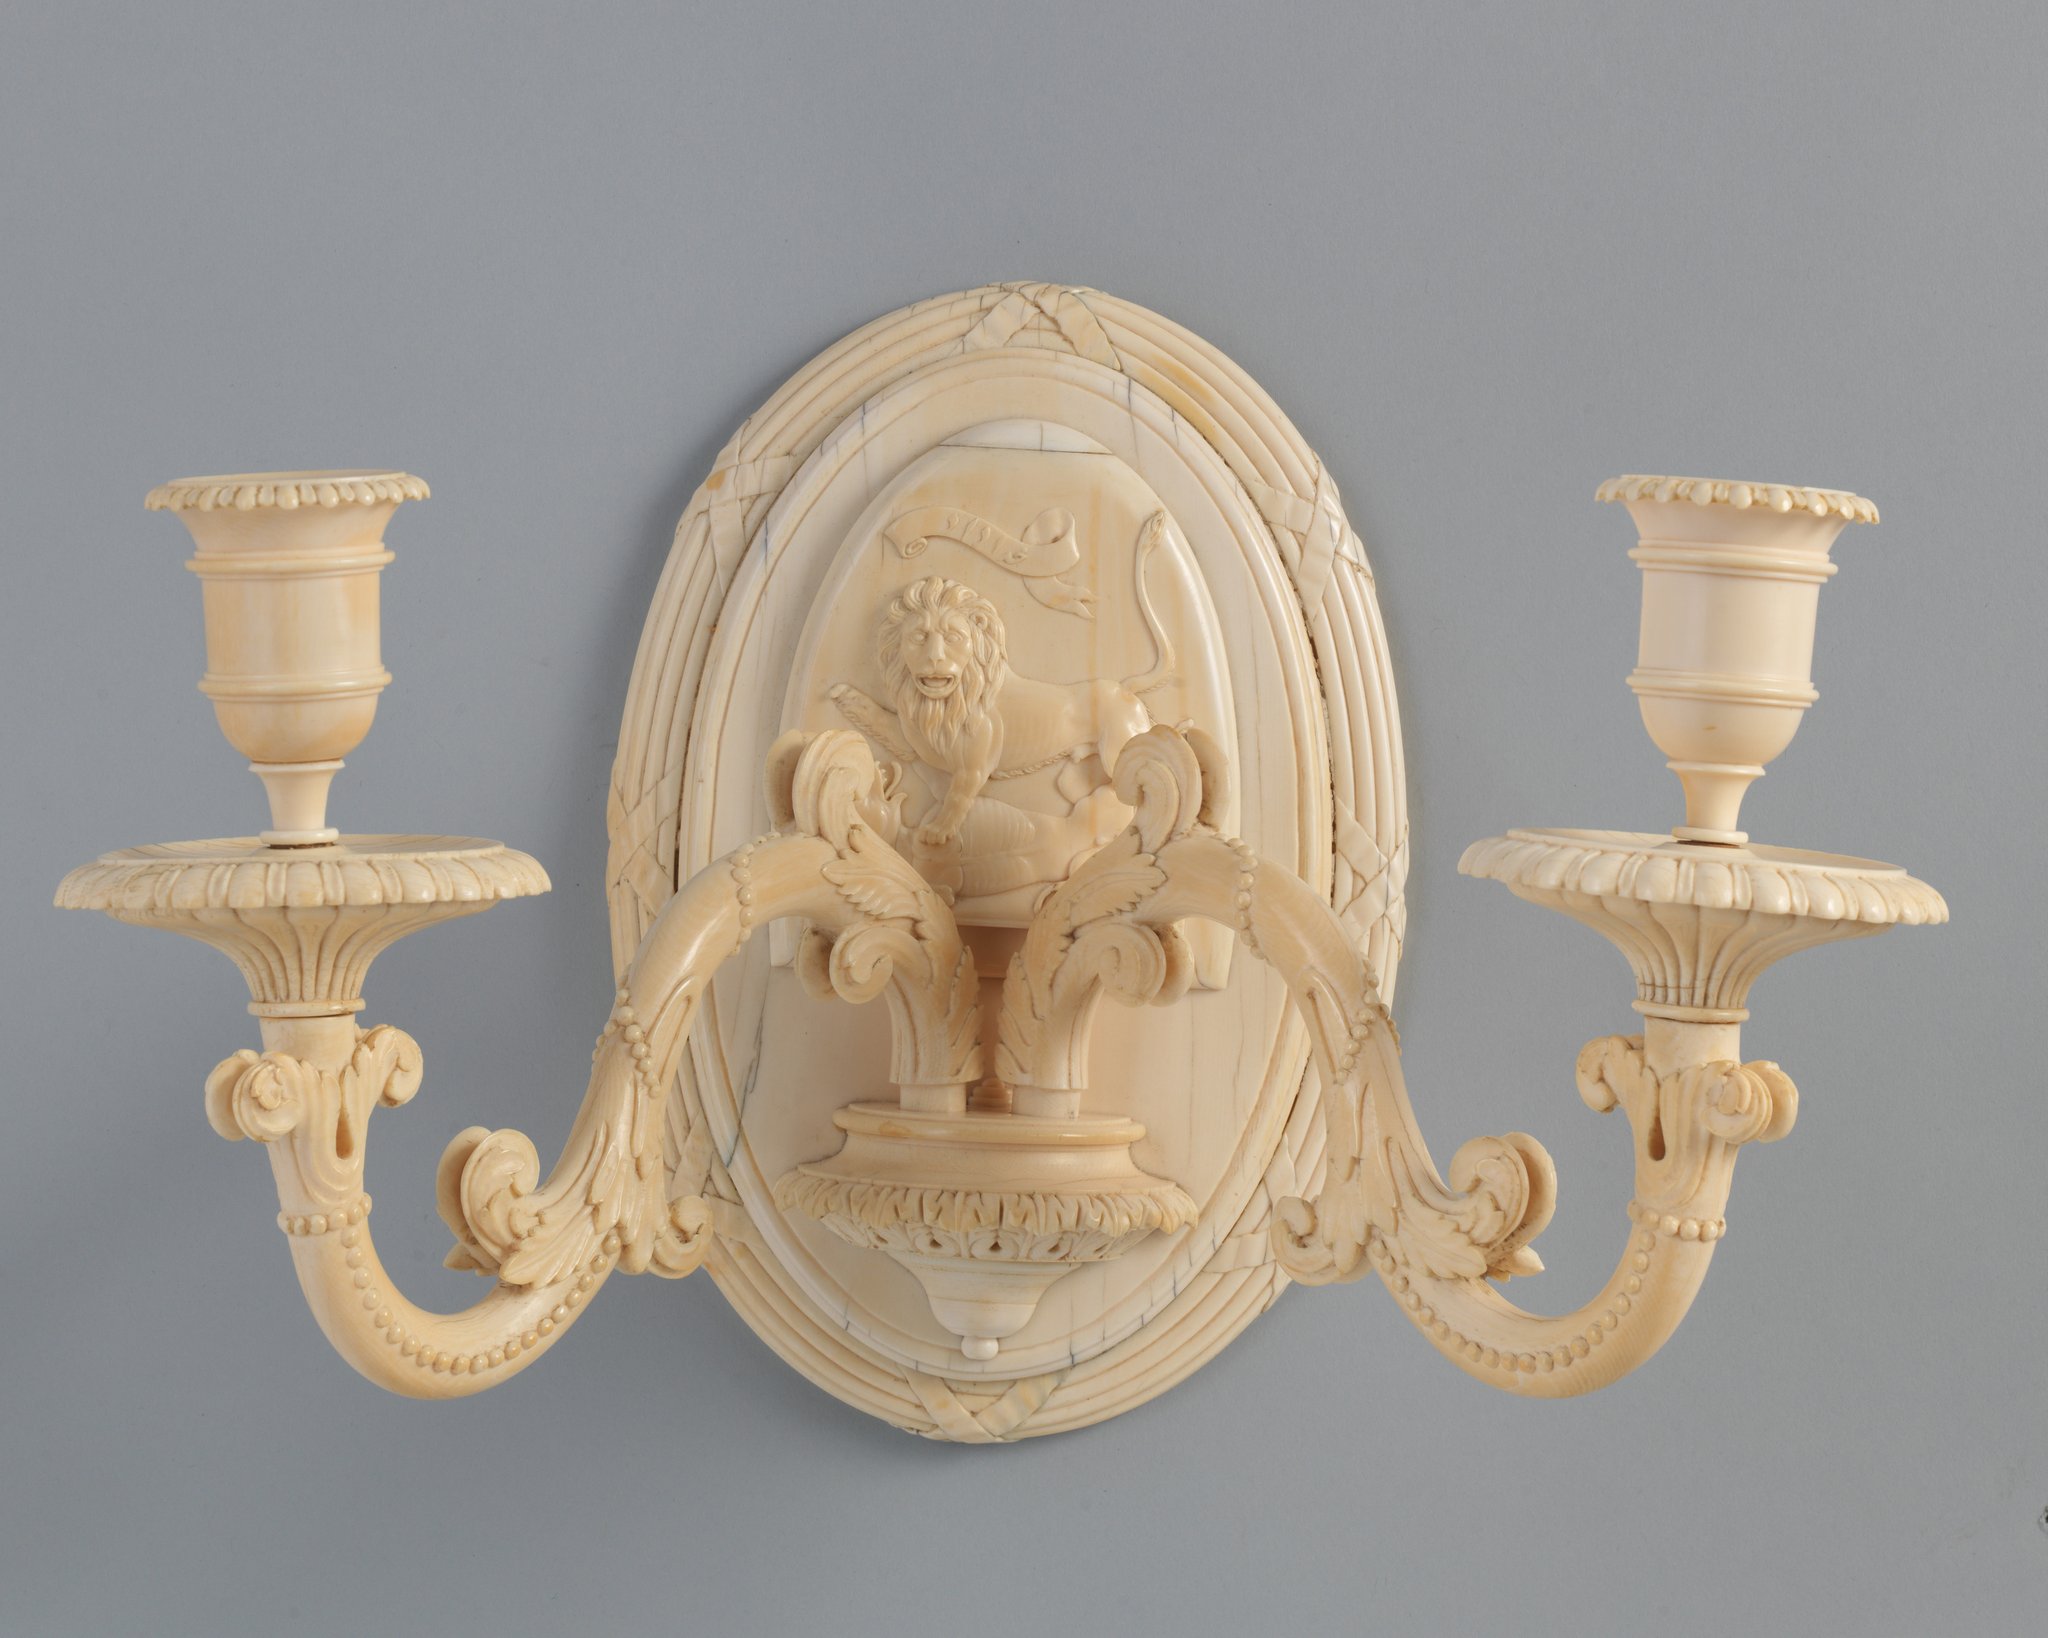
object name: wall bracket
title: Two-light wall bracket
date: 1799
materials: ivory